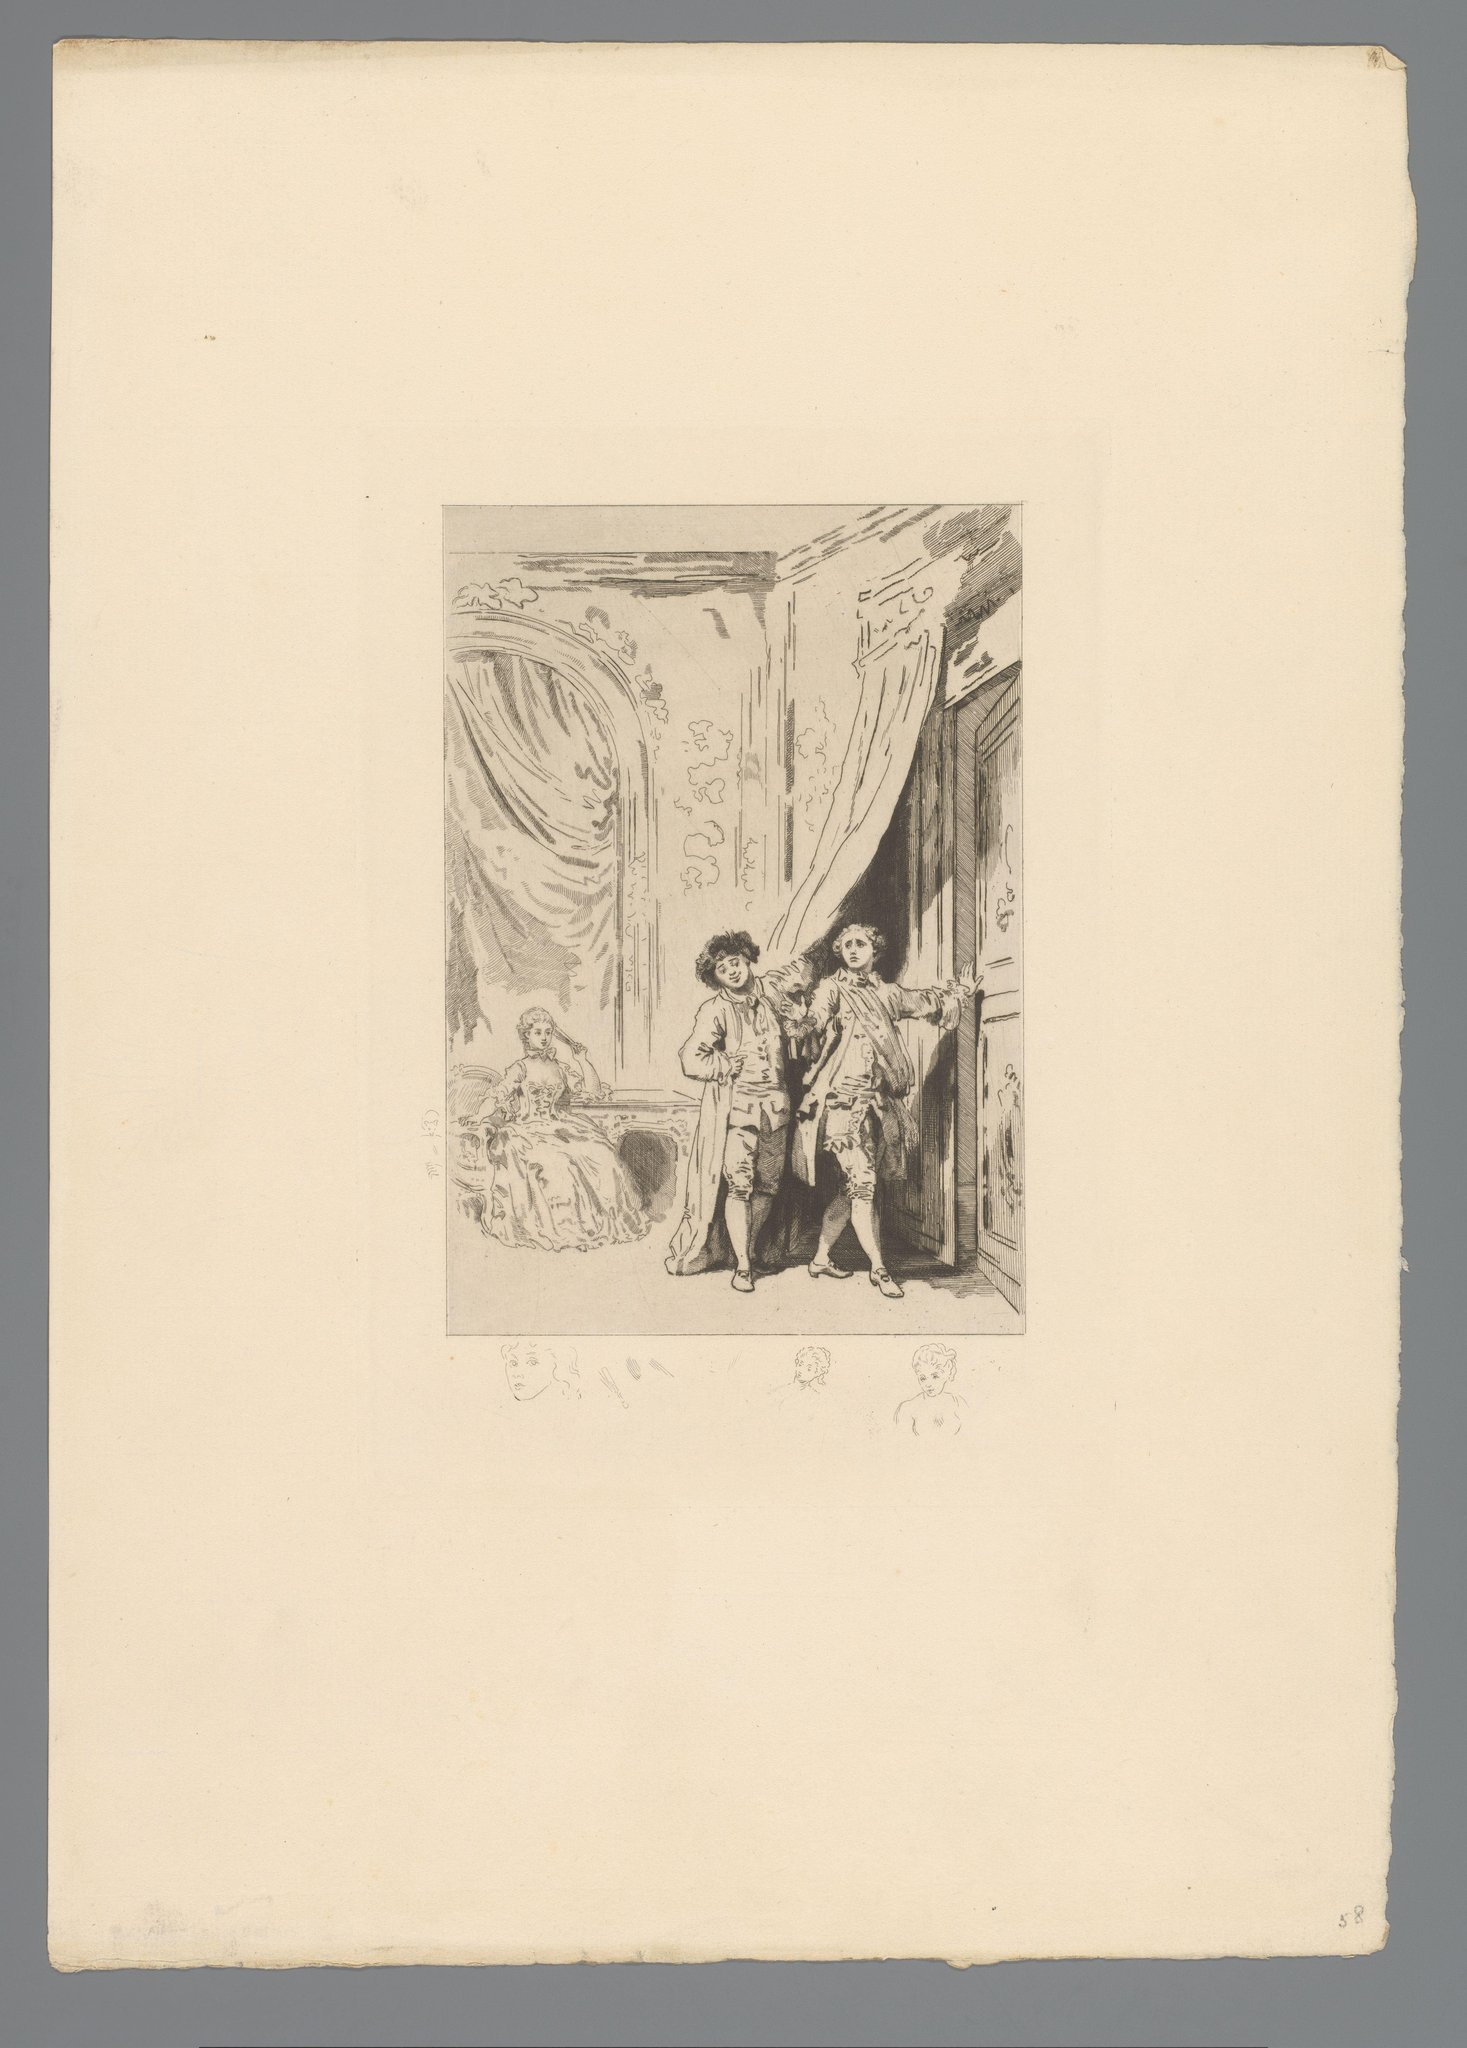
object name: reproduction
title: Figuren uit de verhalen van La Fontaine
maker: Anonymous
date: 1880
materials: paper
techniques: photoaquatint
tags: visiting; receiving guests; elegant company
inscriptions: collector's mark:, collector's mark: Lugt 2228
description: Martial Potémont maakte etsen naar de tekeningen van Fragonard, die zich bevonden in een manuscript in de collectie van de verzamelaar Eugène Paillet. Rouquette bood hem aan de tekeningen zo exact mogelijk in prent te laten brengen door Martial Potémont: dit resulteerde in een serie van 57 etsen. Vervolgens werden deze gereproduceerd door middel van heliogravure. Deze omslag betreft een editie voor de letter, "Eau forte pure", de 1e staat van 3 waar men uit kon kiezen bij deze serie.